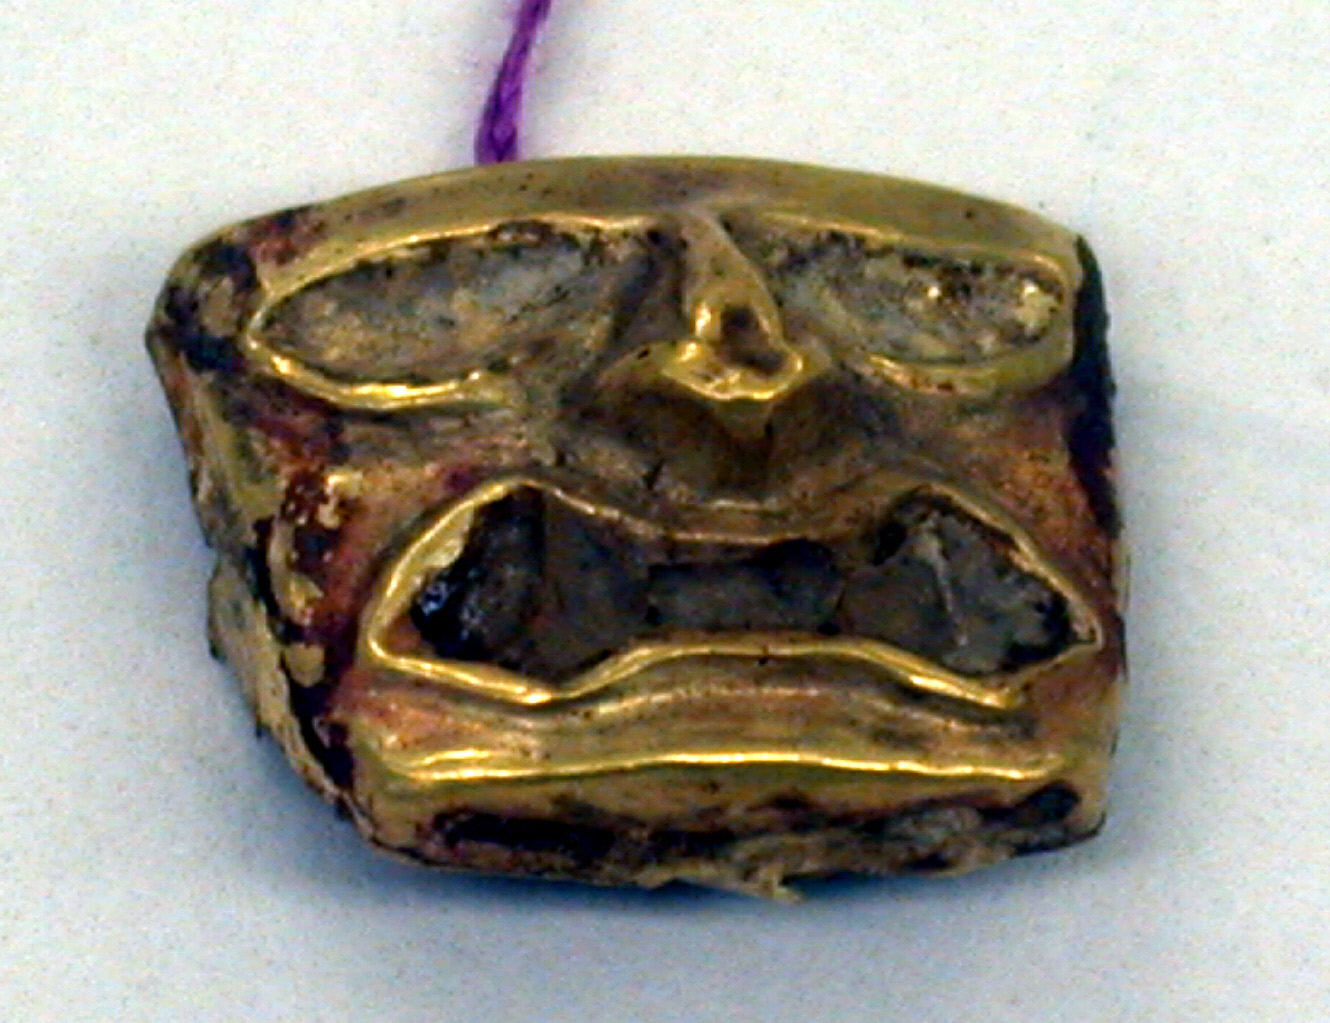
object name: ornament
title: Gold Face Mask Ornament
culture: moche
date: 501-700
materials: gold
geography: peru